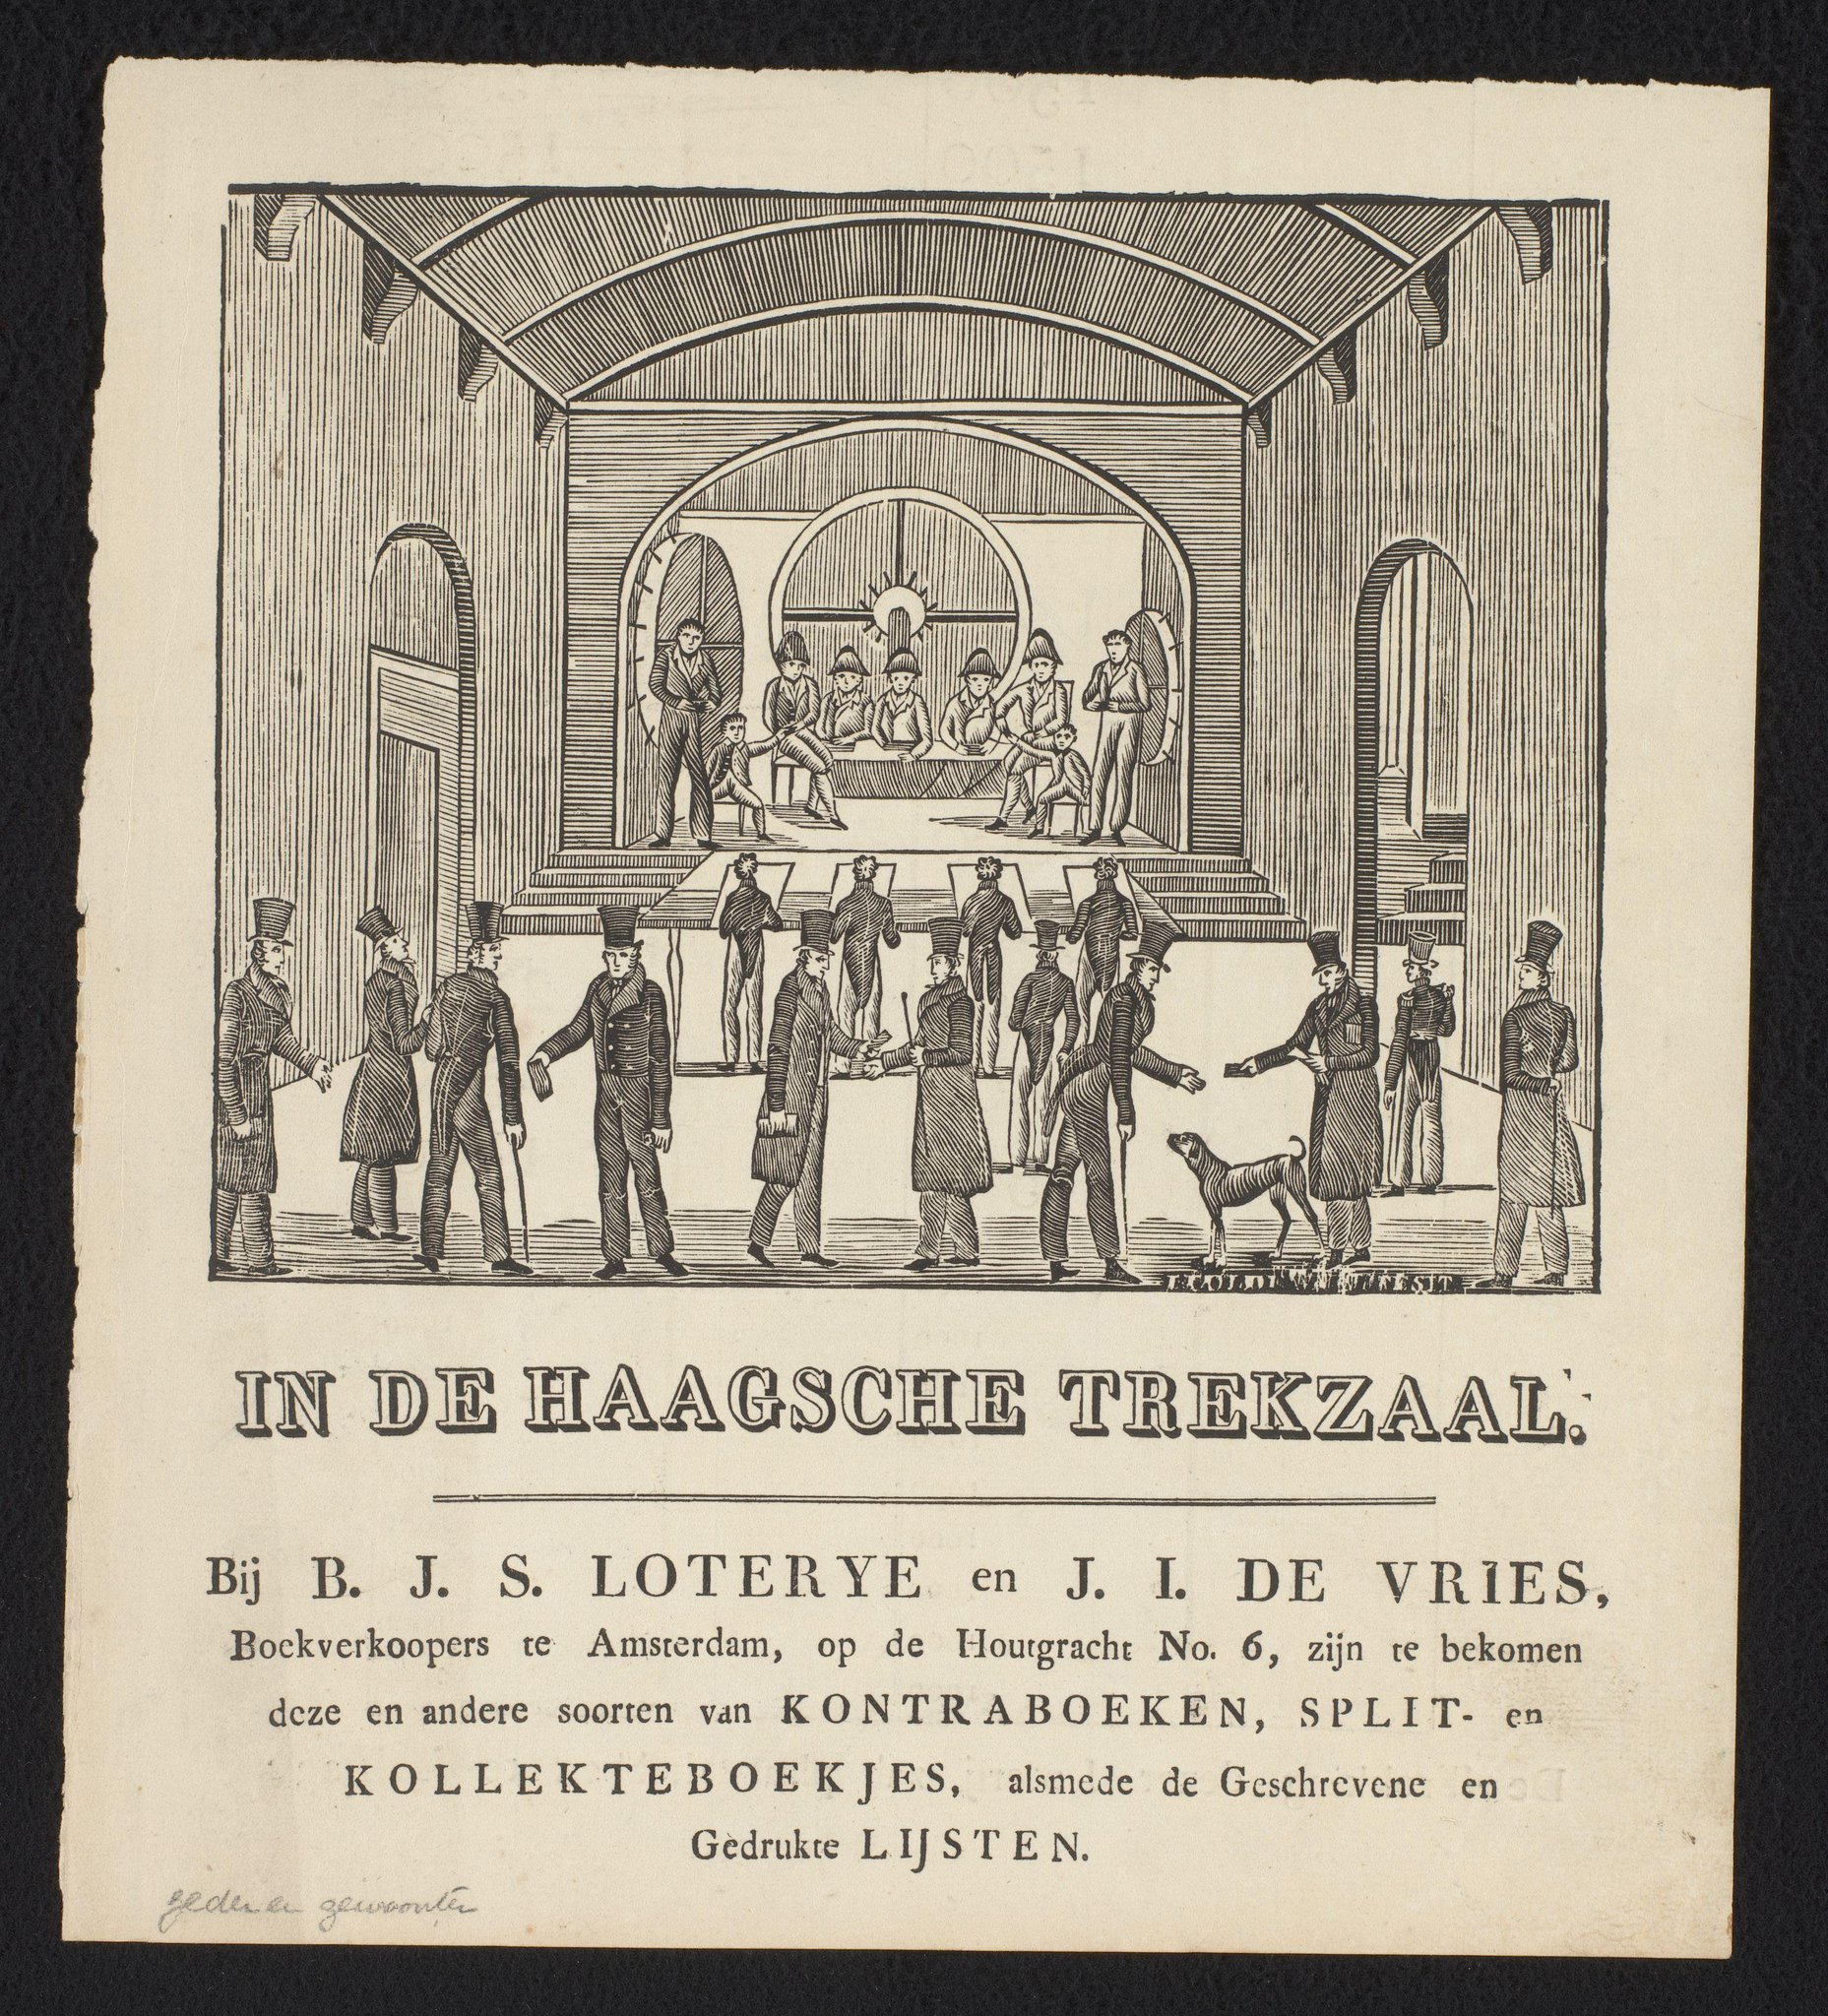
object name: print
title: In de Haagsche trekzaal. Bij B.J.S. Loterye en J.I. de Vries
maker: Anonymous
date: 1800-1825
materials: paper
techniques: letterpress printing, pen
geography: the hague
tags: drawing lots ~ betting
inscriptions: collector's mark: Lugt 2233